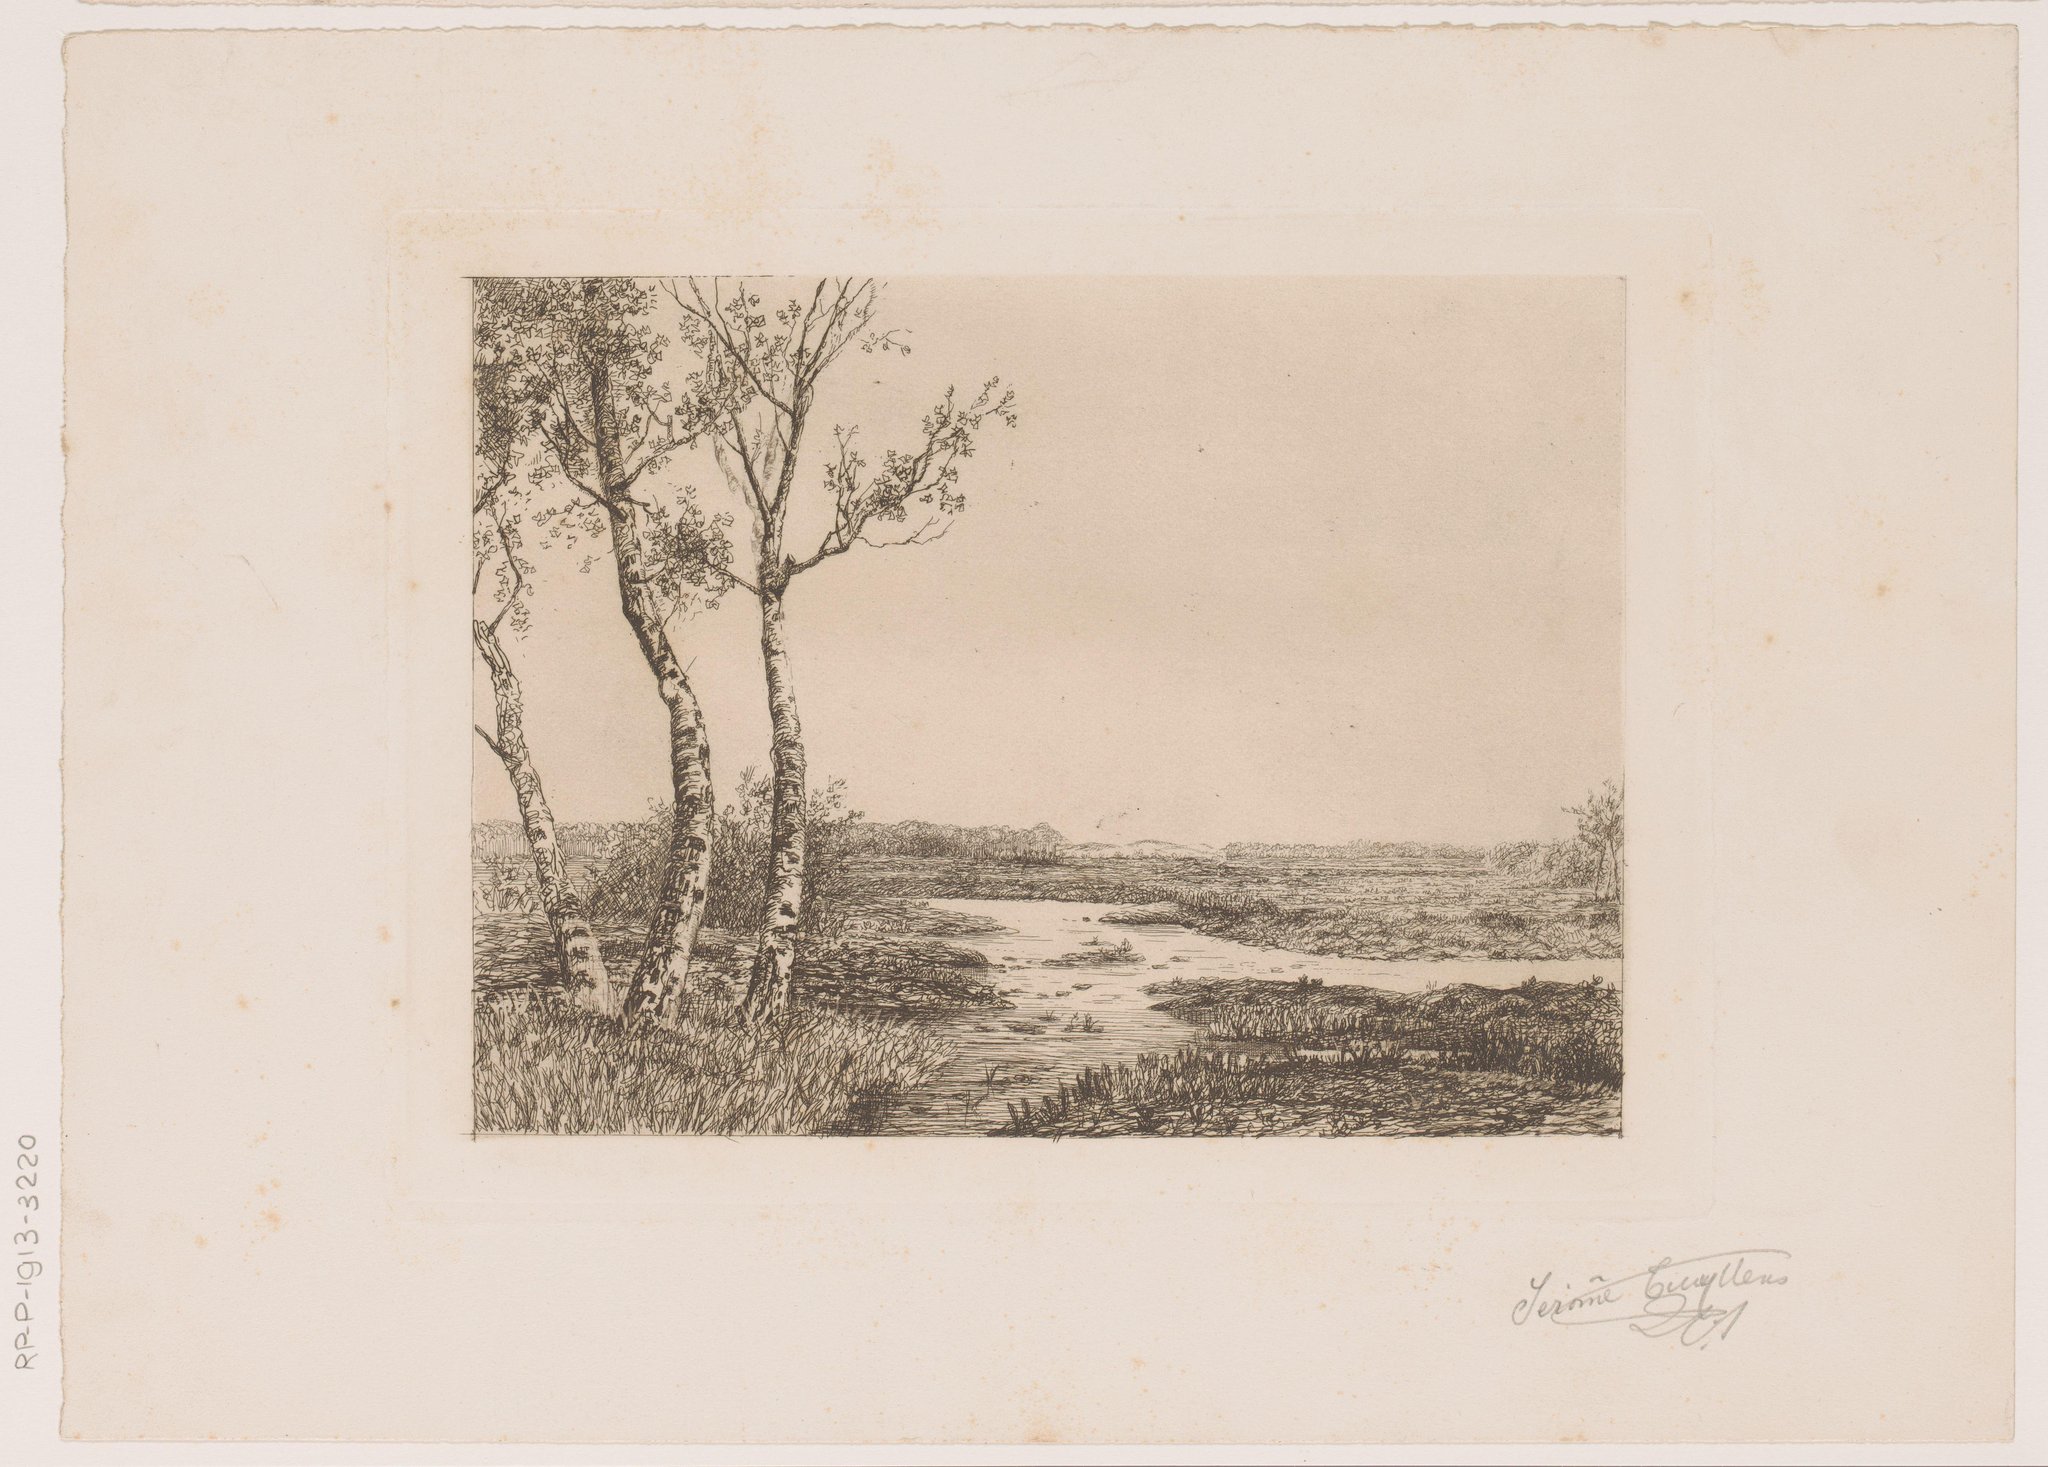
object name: print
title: Landschap met drie berken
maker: jerôme tuyttens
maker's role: painter, print maker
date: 1850-1883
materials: paper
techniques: drypoint, etching, intaglio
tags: water course, trees: birch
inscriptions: collector's mark: Lugt 2228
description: Sterfdatum van de prentmaker is onbekend. Daarom is voor de bepaling van de rechten van dit object gebruik gemaakt van de verwervingsdatum Rijksmuseum Amsterdam.